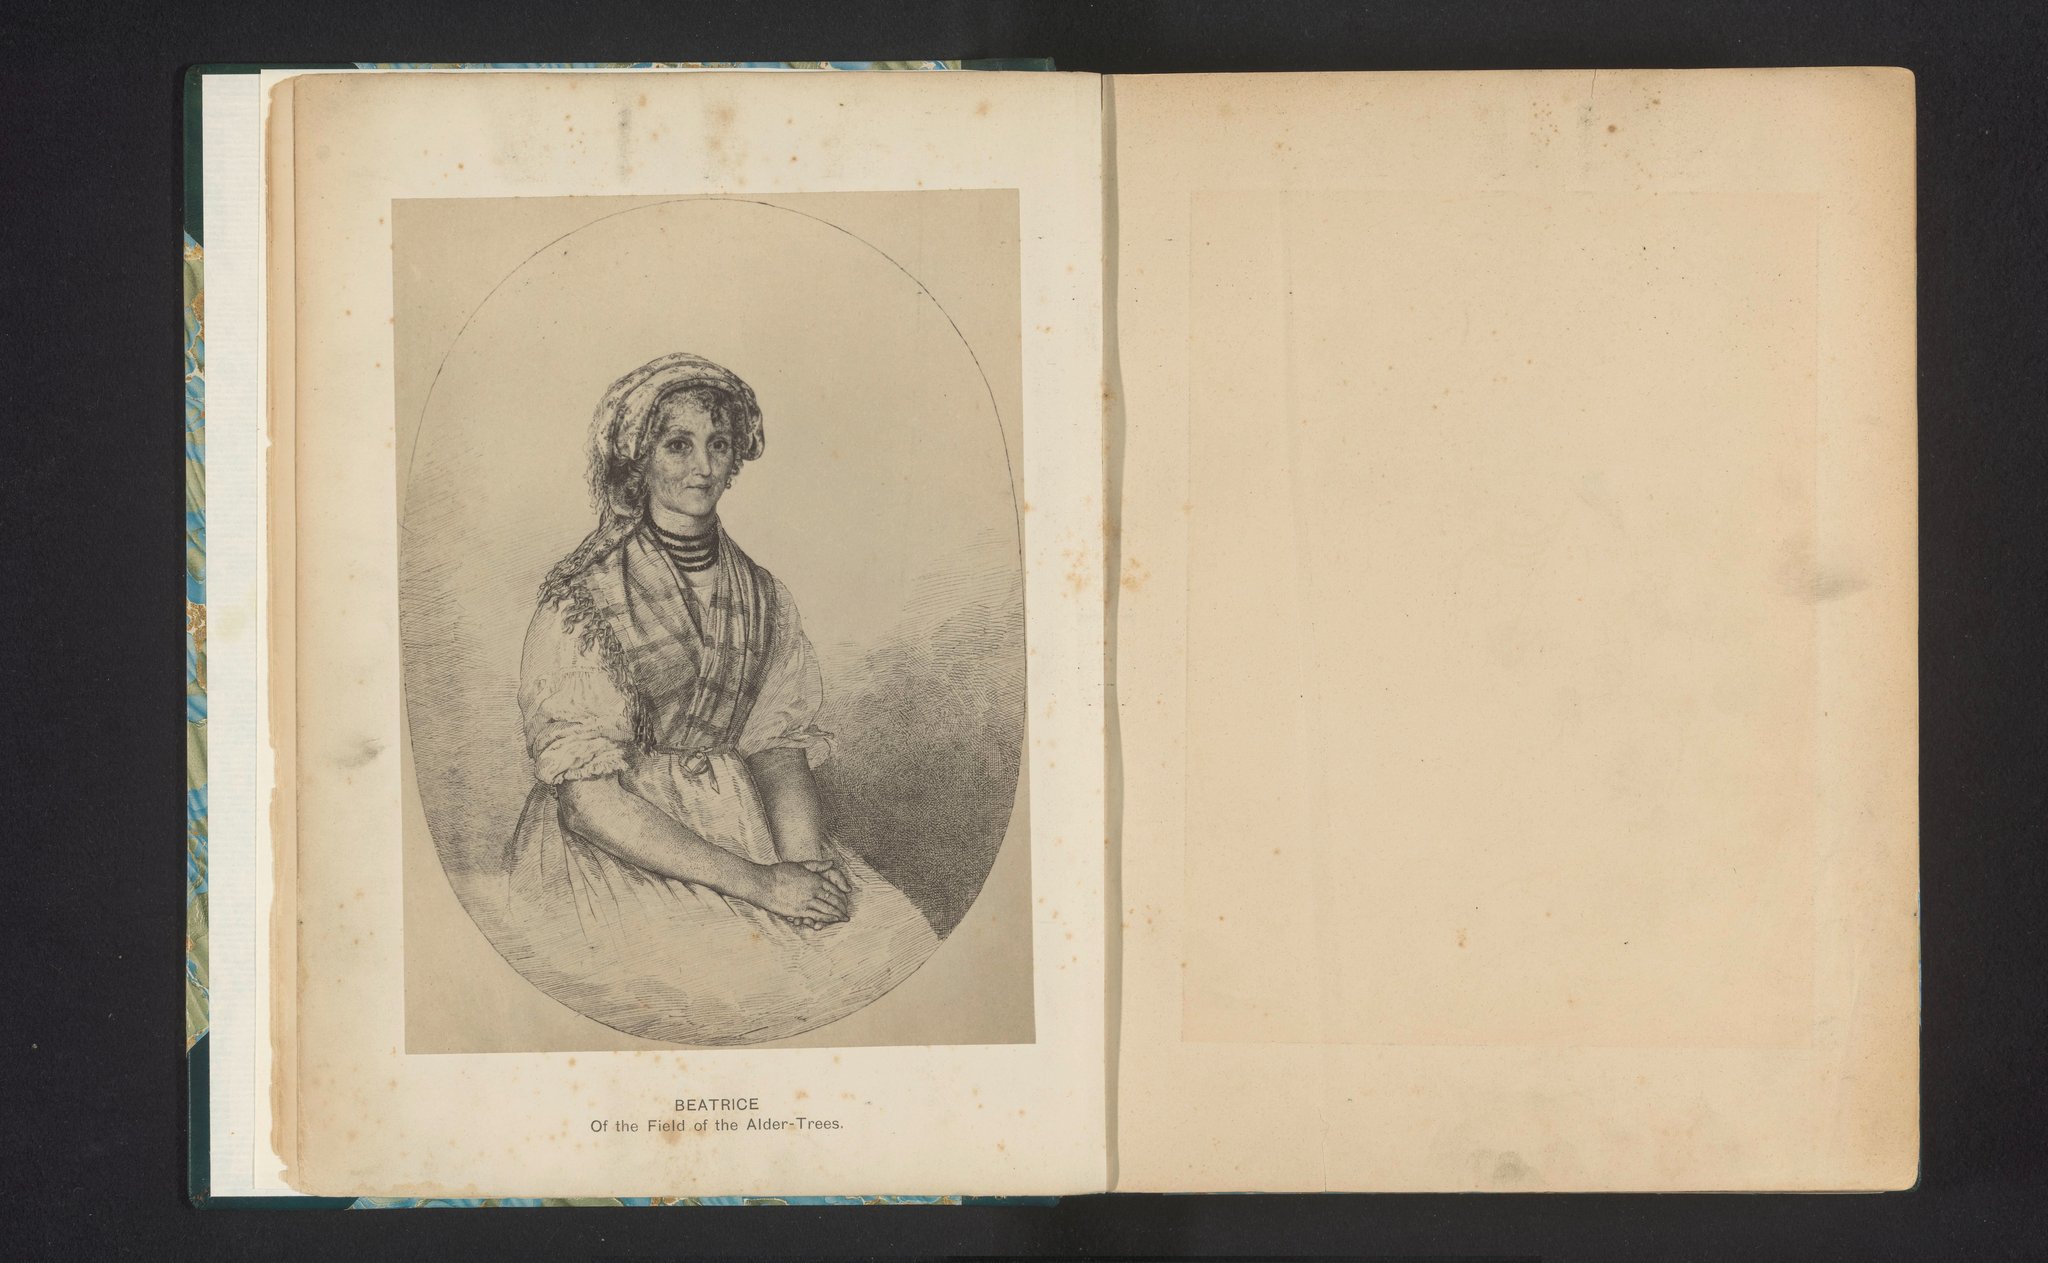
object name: page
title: Beatrice of the field of the alder-trees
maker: frederick hollyer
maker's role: fotograaf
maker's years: 1838-1933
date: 1875-1885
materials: photographic support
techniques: platinum process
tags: portrait of a writer